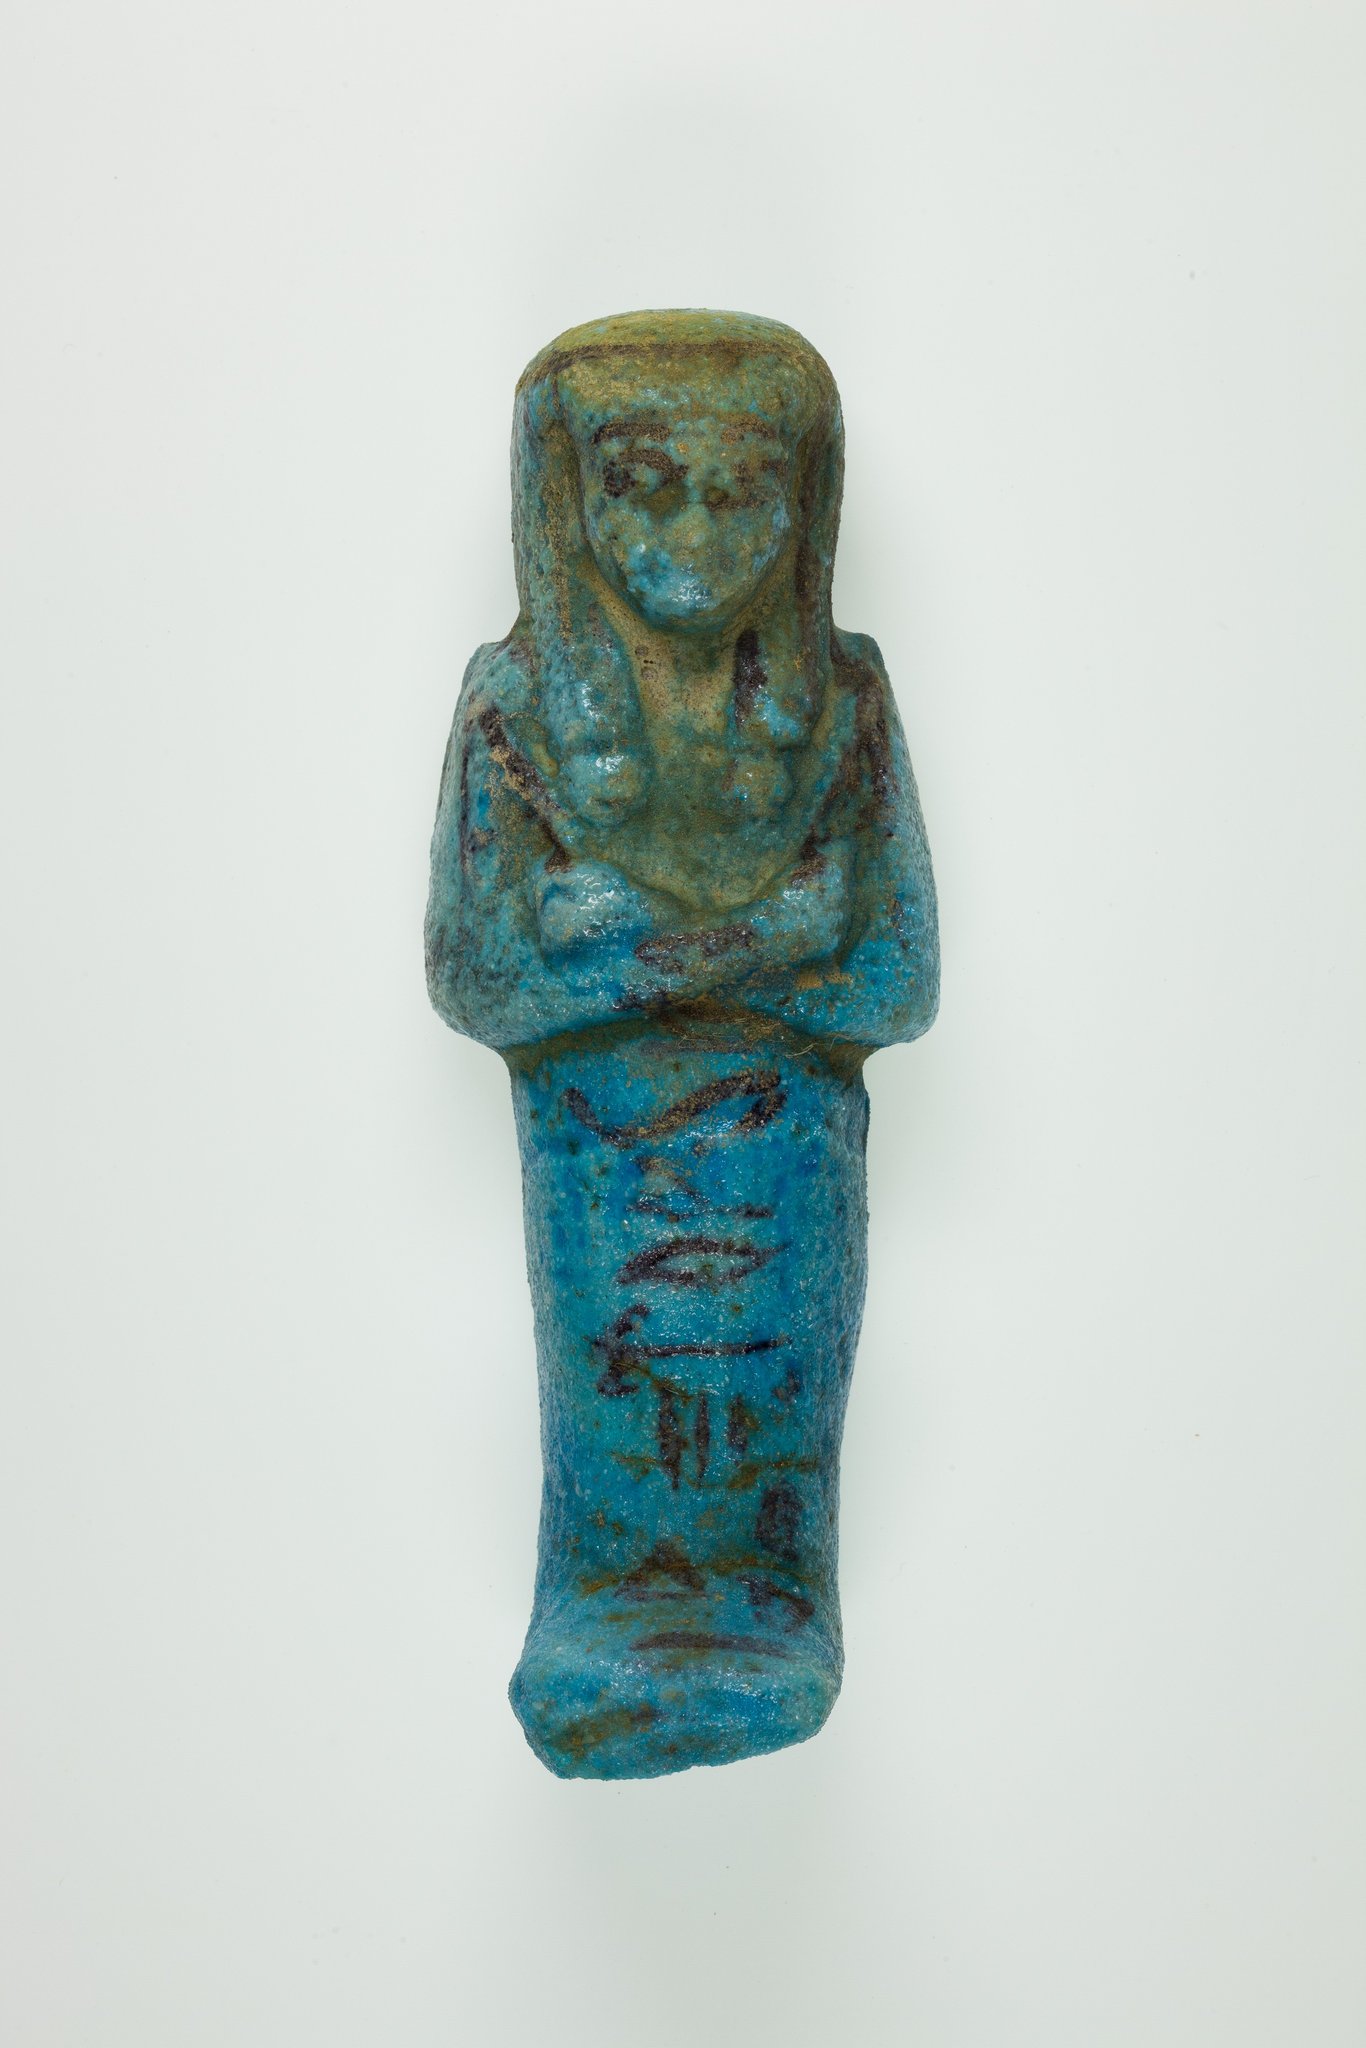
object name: worker shabti, henettawy c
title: Worker Shabti of Henettawy (C), Daughter of Isetemkheb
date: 990-970 BCE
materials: faience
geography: egypt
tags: hieroglyphs